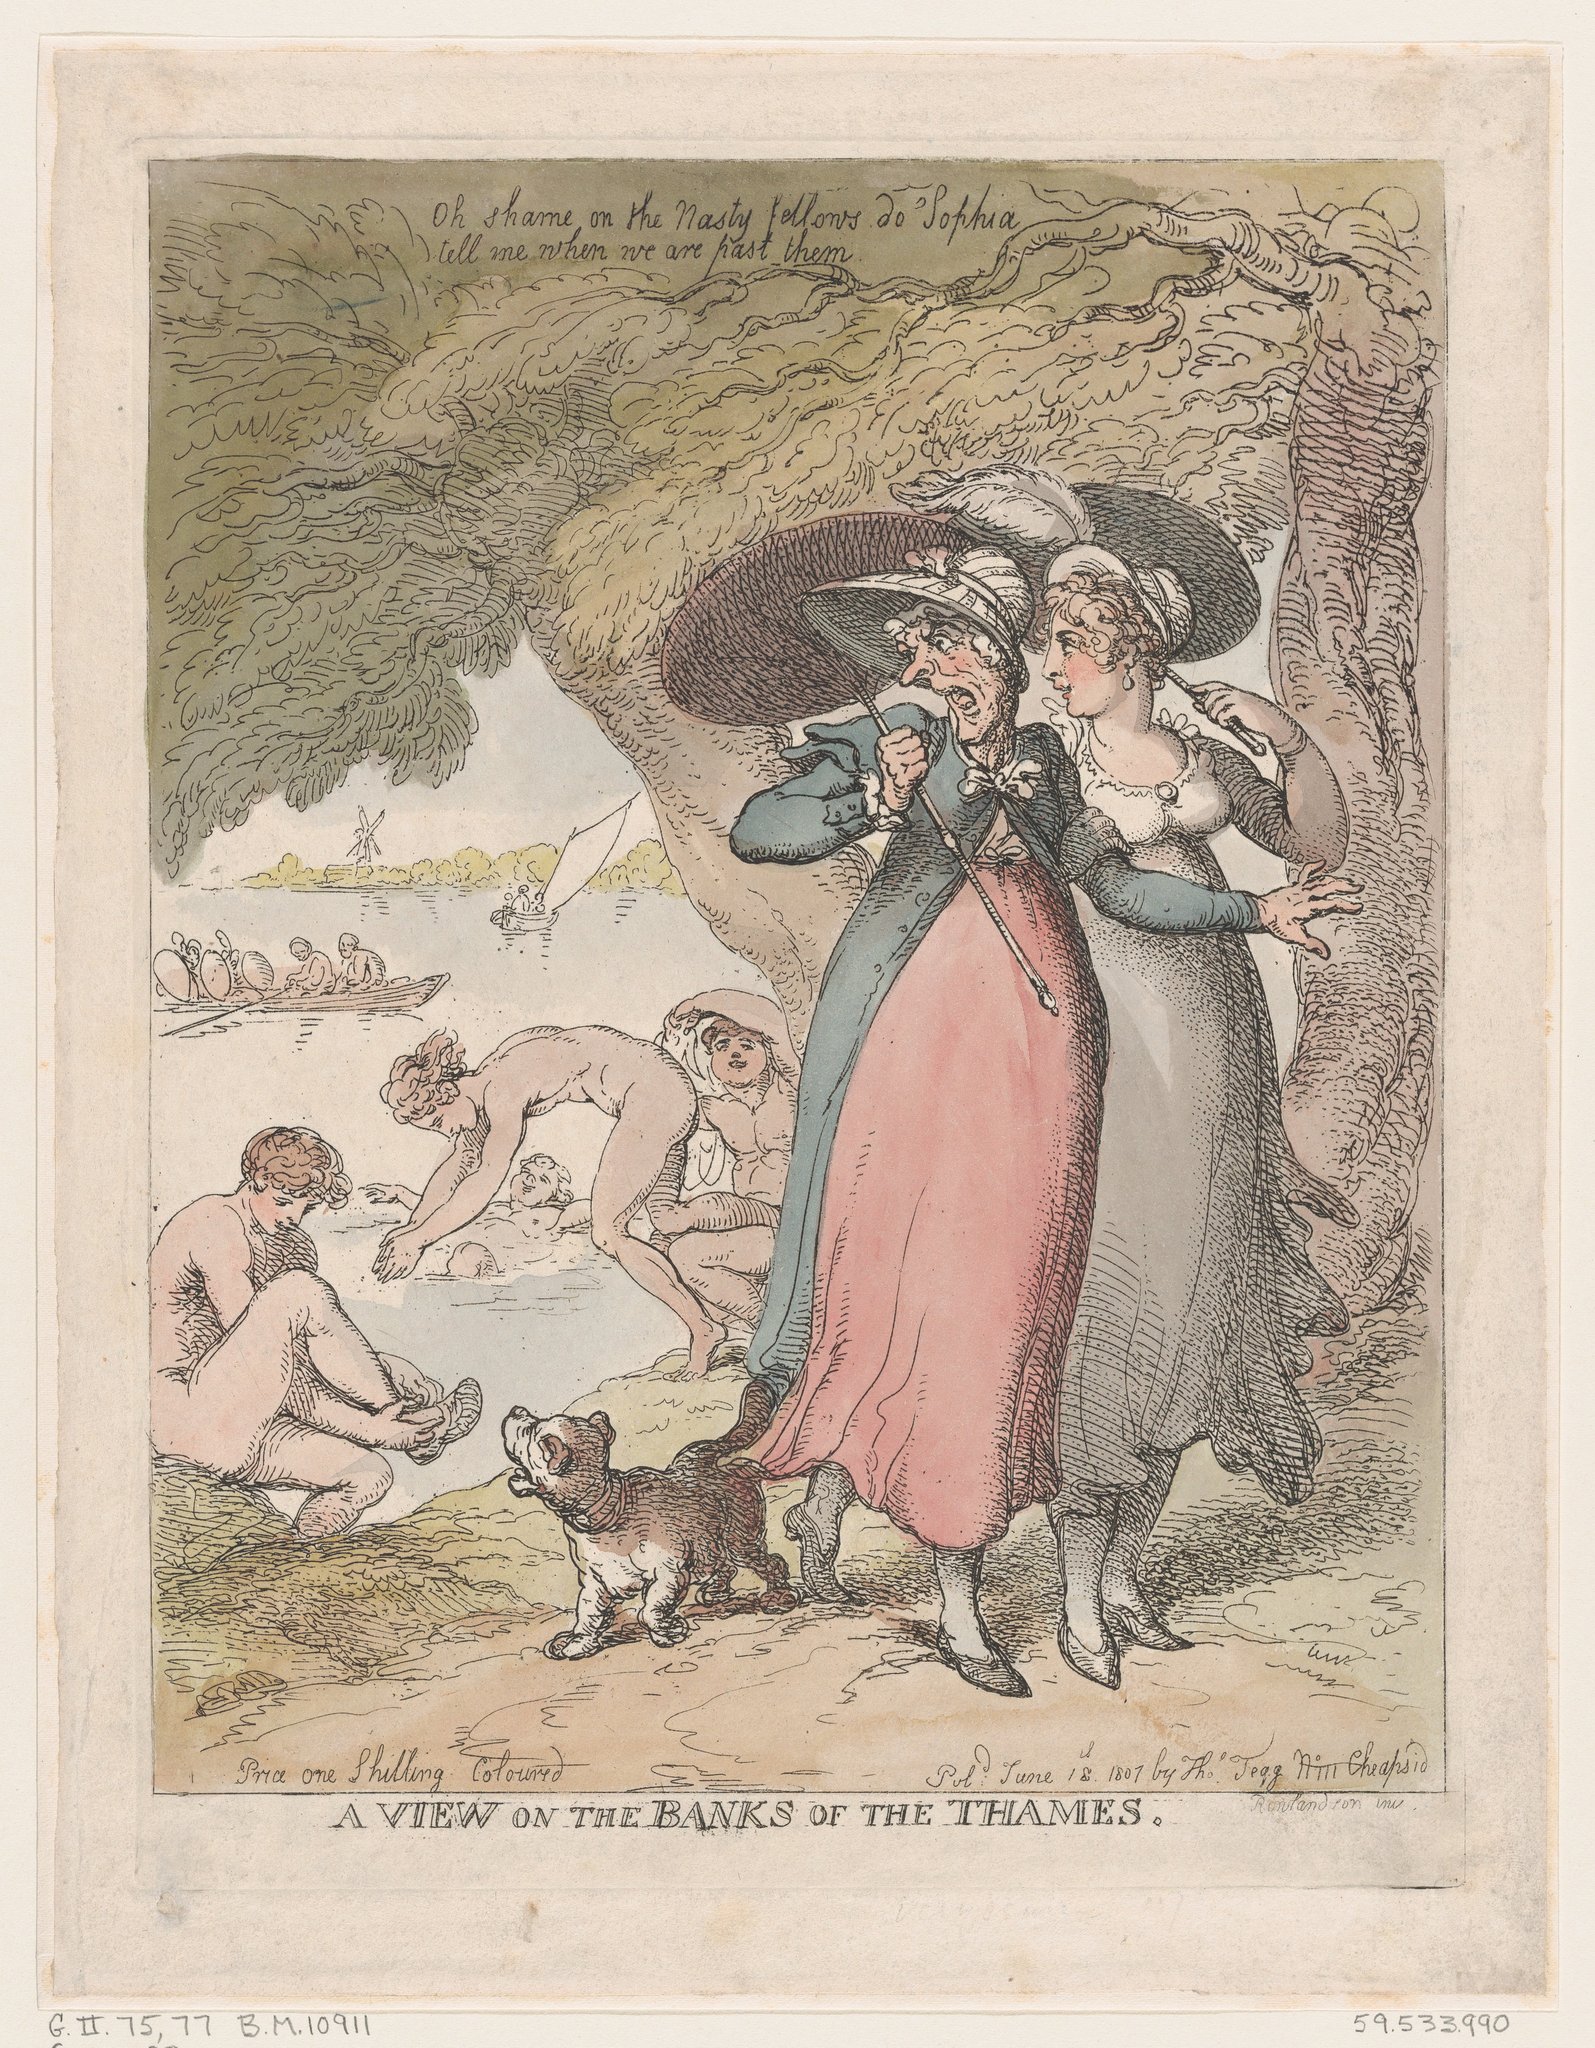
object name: print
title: A View on the Banks of the Thames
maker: thomas rowlandson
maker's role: artist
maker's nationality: british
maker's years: 1757-1827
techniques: etching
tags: satire,men,women,dogs